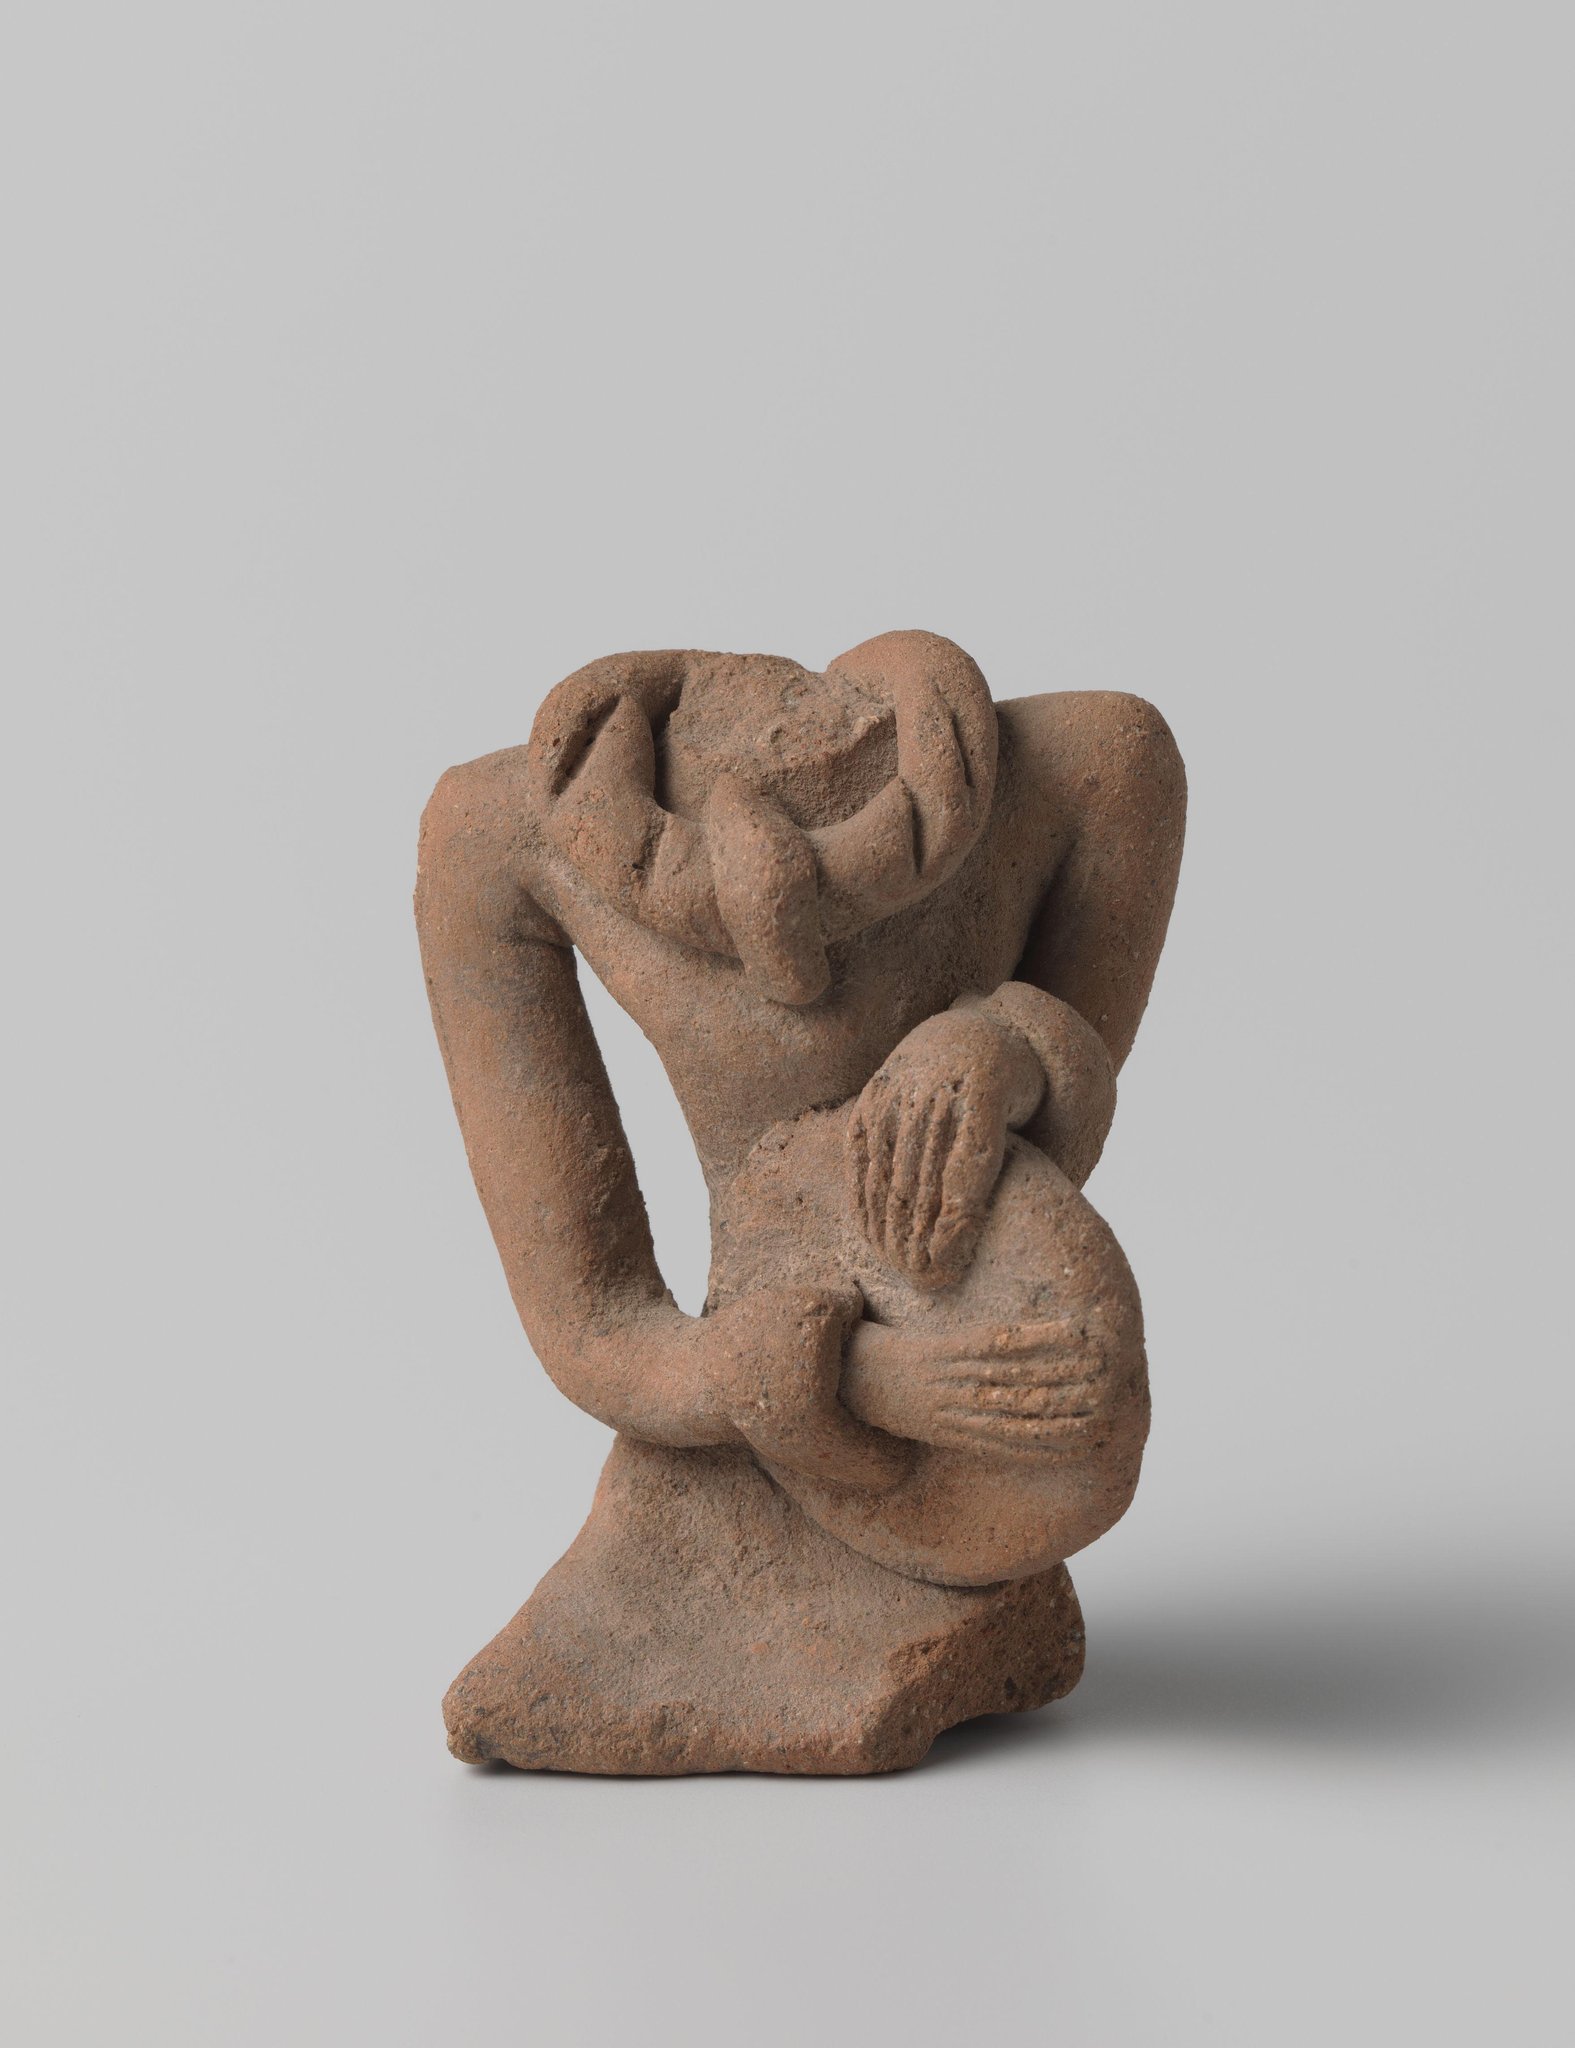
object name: figure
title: Zittend figuur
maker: Anonymous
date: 1300-1499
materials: terracotta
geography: east java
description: Terracotta figuur, zonder hoofd en benen. Het lichaam, voorzien van dik aangegeven armbanden en halssnoer, vertoont een enigszins gedraaide houding en de armen houden een rond, plat voorwerp vast. Mogelijk een offerschaal of trommel?